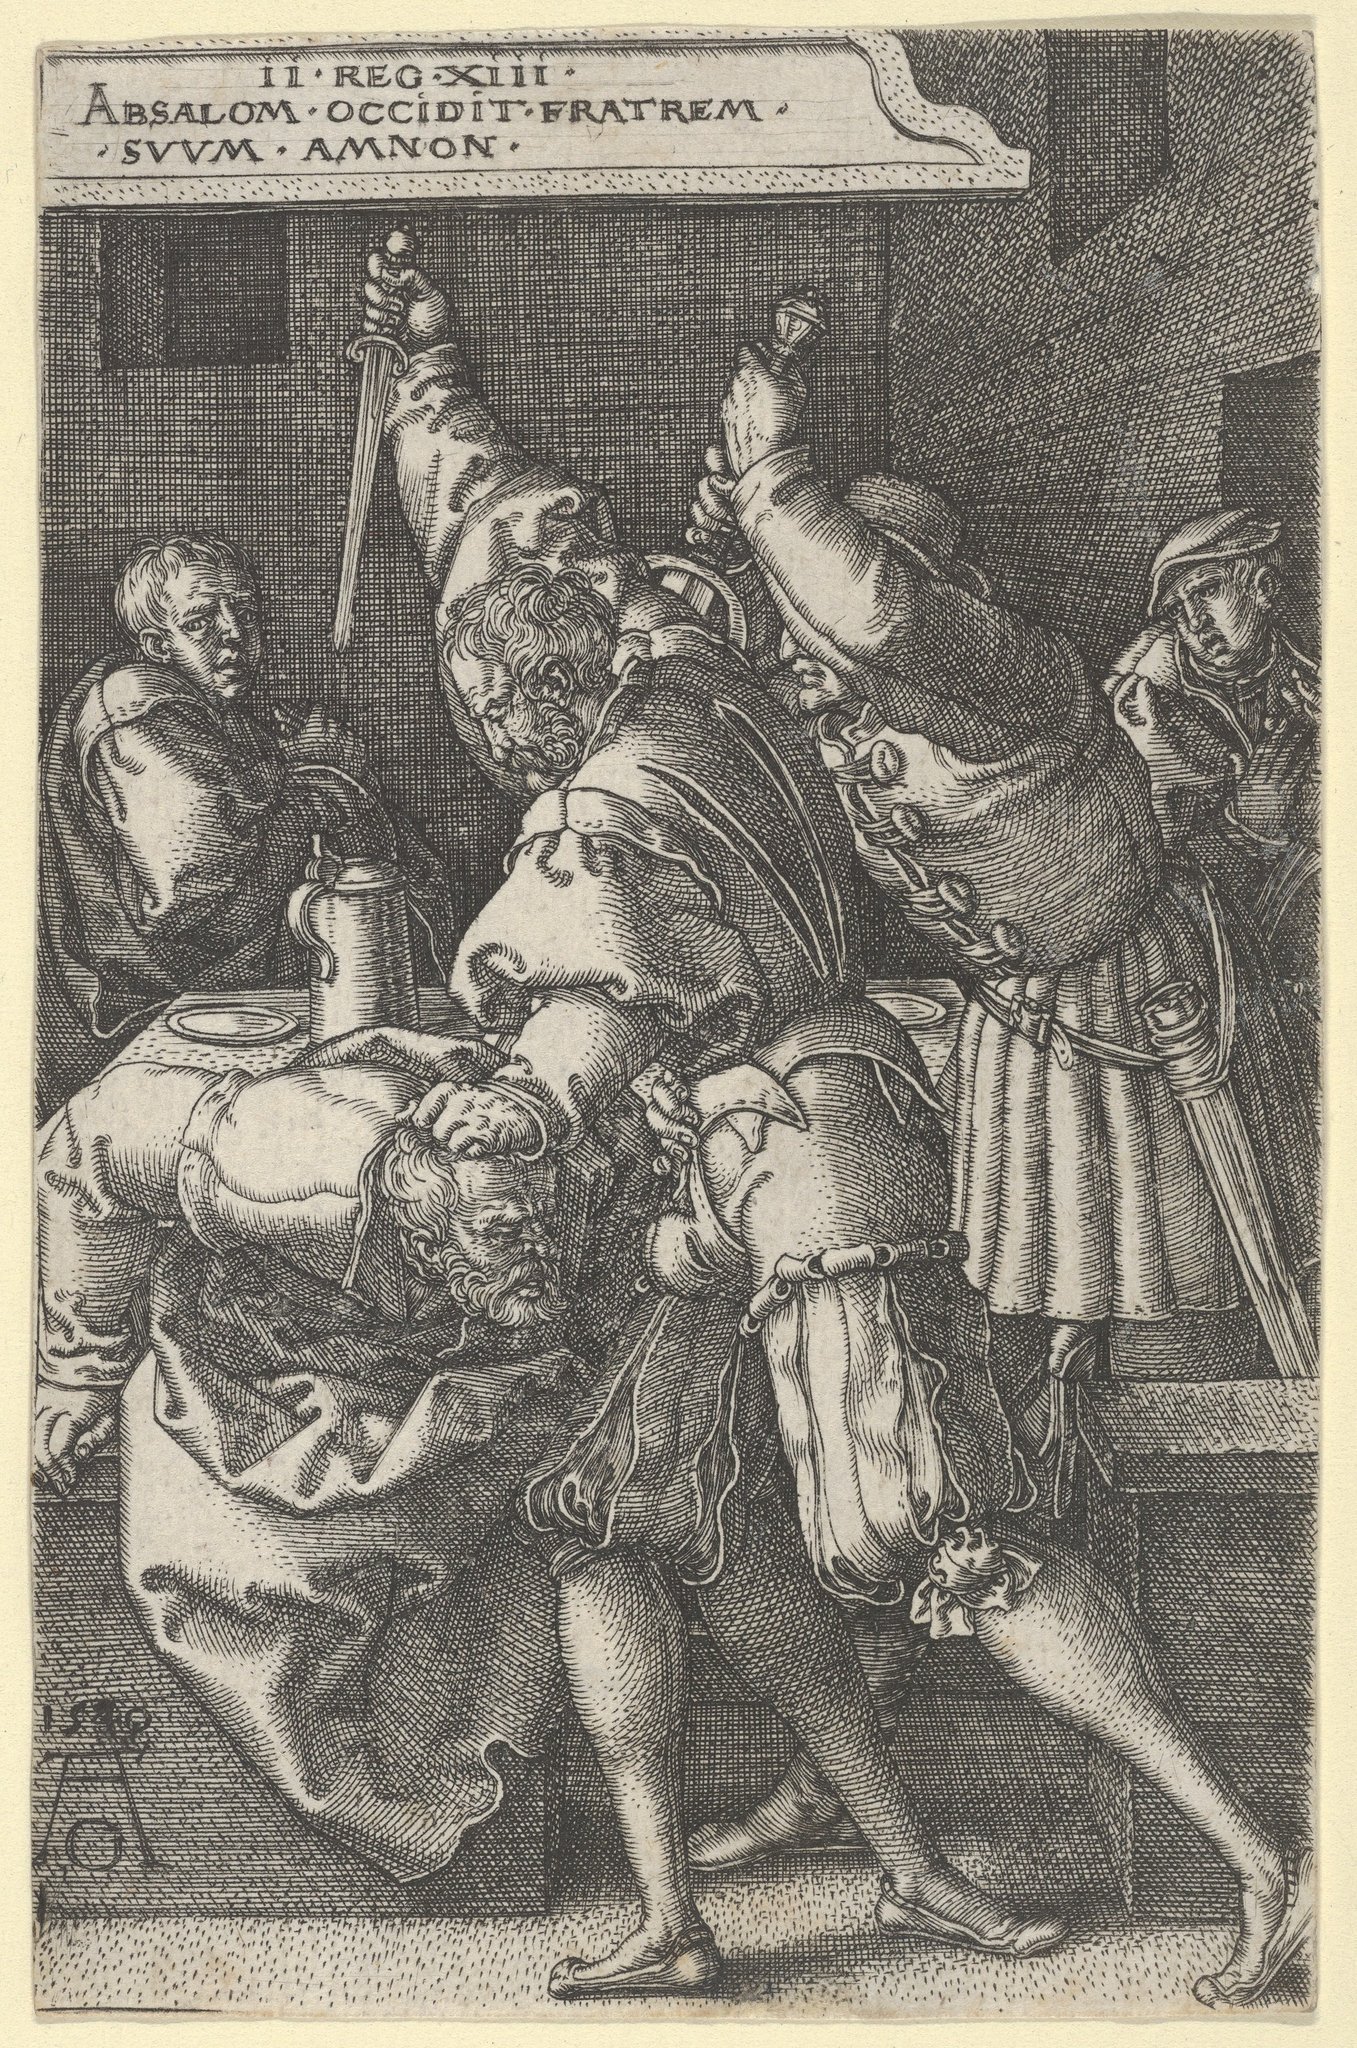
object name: print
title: The Servants of Absalom Killing Amnon, from "The Story of Amnon and Tamar"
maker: heinrich aldegrever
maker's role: artist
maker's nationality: german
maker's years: 1502-1561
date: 1540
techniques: engraving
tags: suffering,men,servants